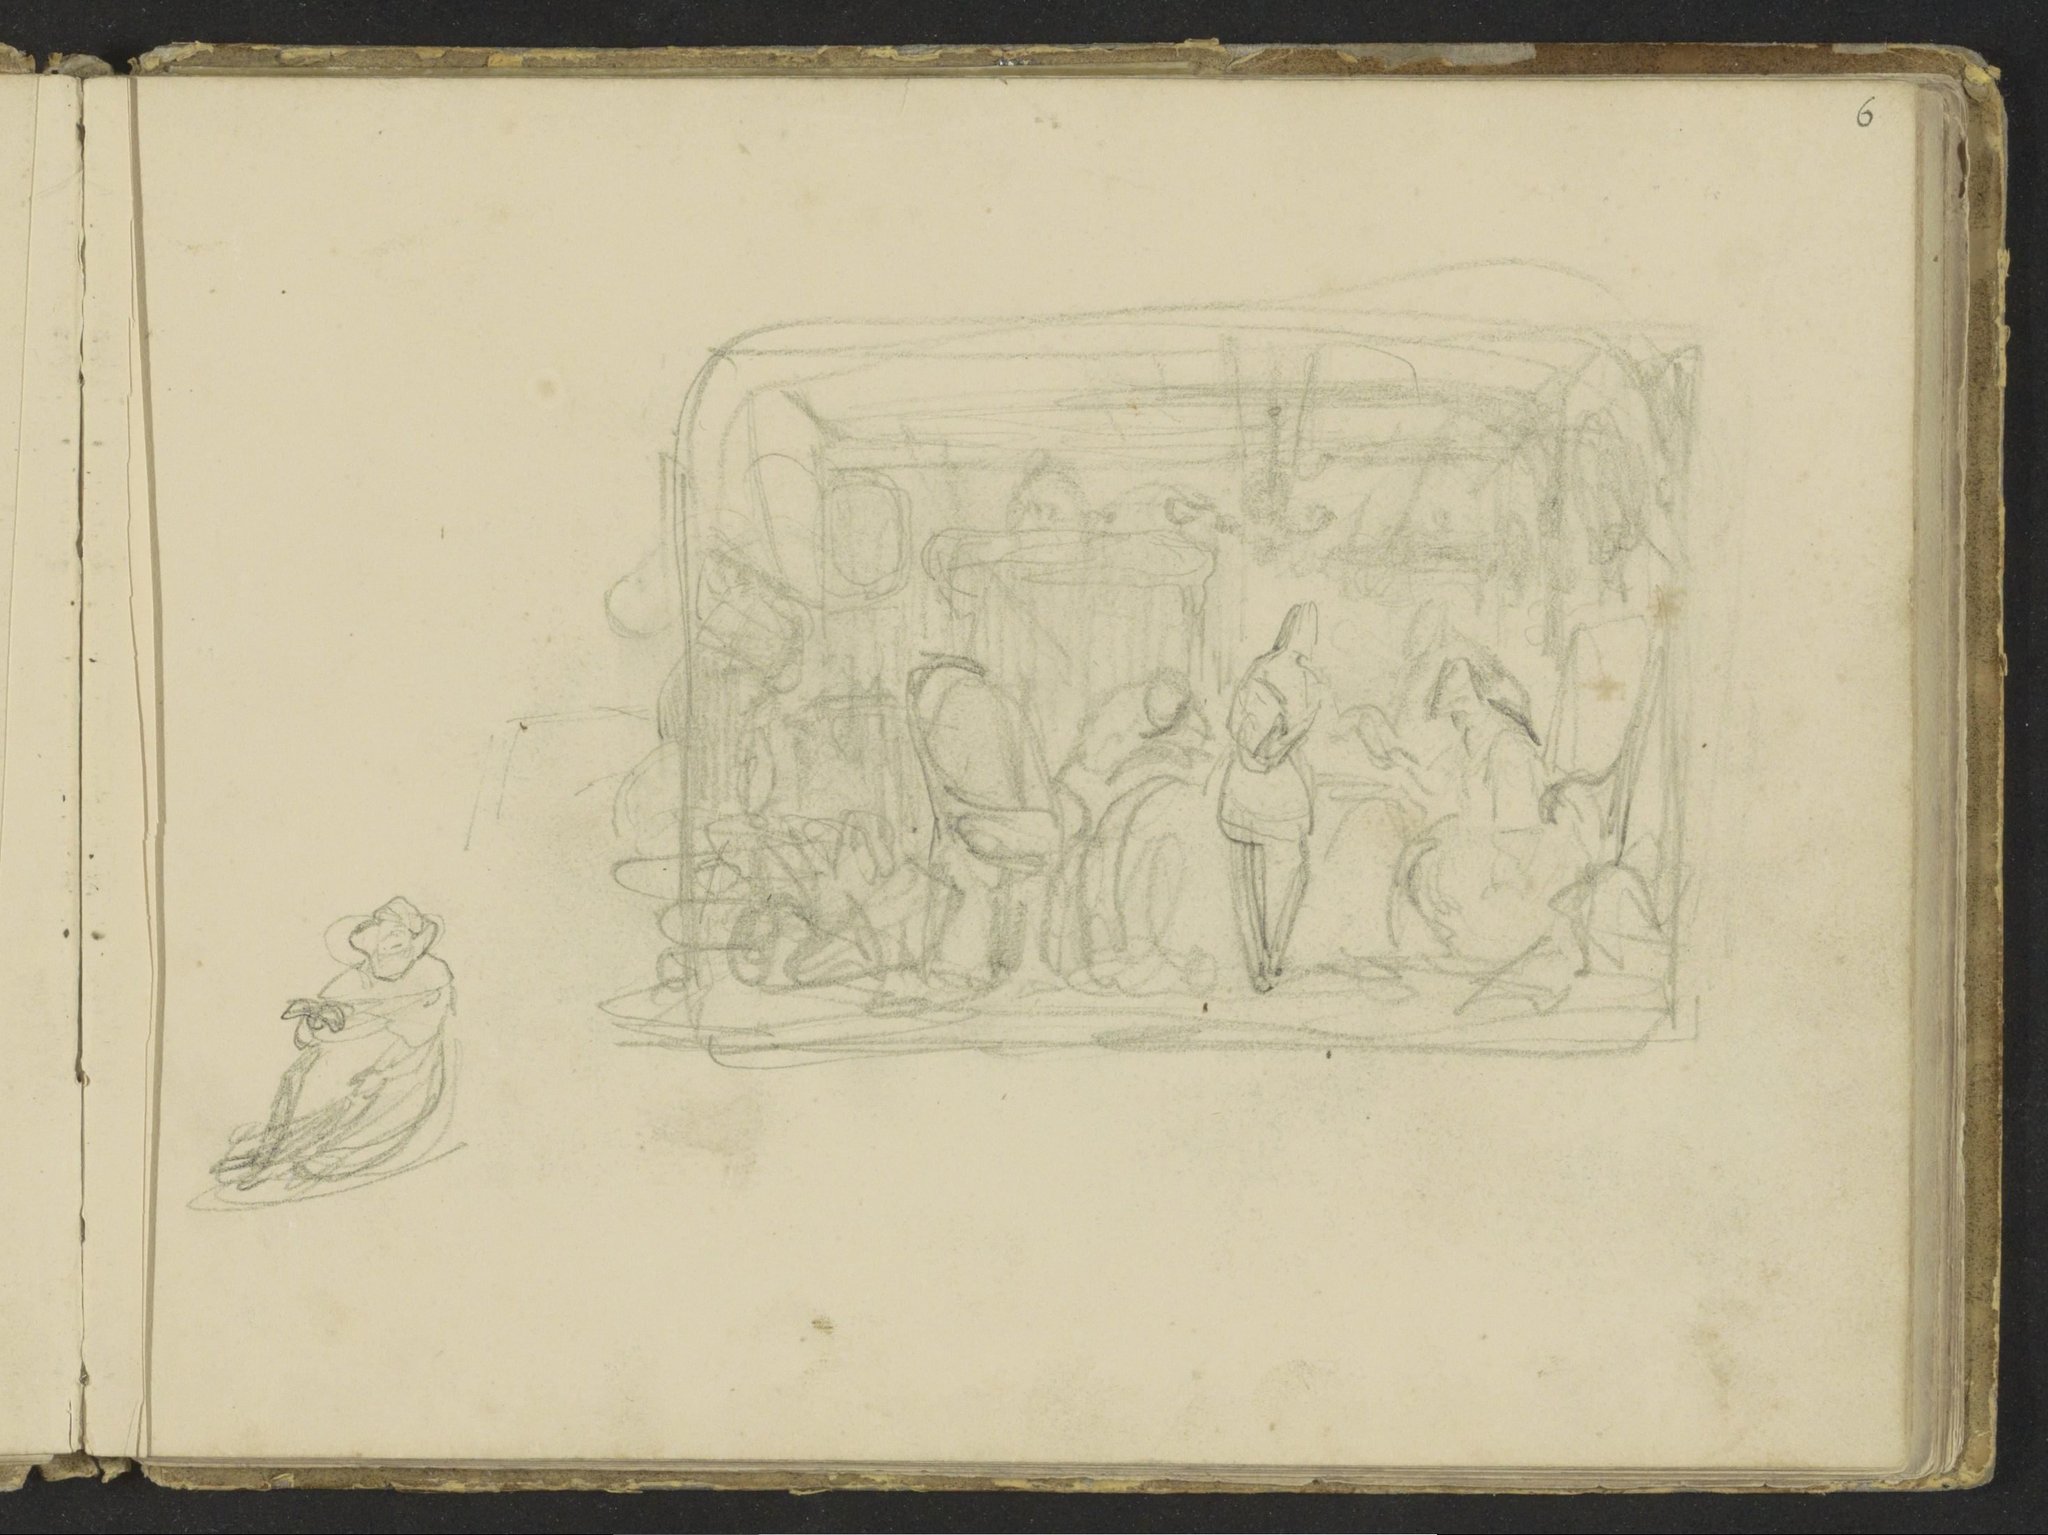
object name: sketchbook leaf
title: Interieur met staande en zittende figuren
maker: willem hendrik schmidt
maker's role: draughtsman, painter, print maker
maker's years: 1809-1849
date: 1819-1849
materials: paper, pencil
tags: sitting figure, interior of the house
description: Tevens een studie van een zittende figuur. Tekening in een kader. Vermoedelijk een compositieschets voor een schilderij. Blad 6 recto uit een schetsboek met 36 bladen.